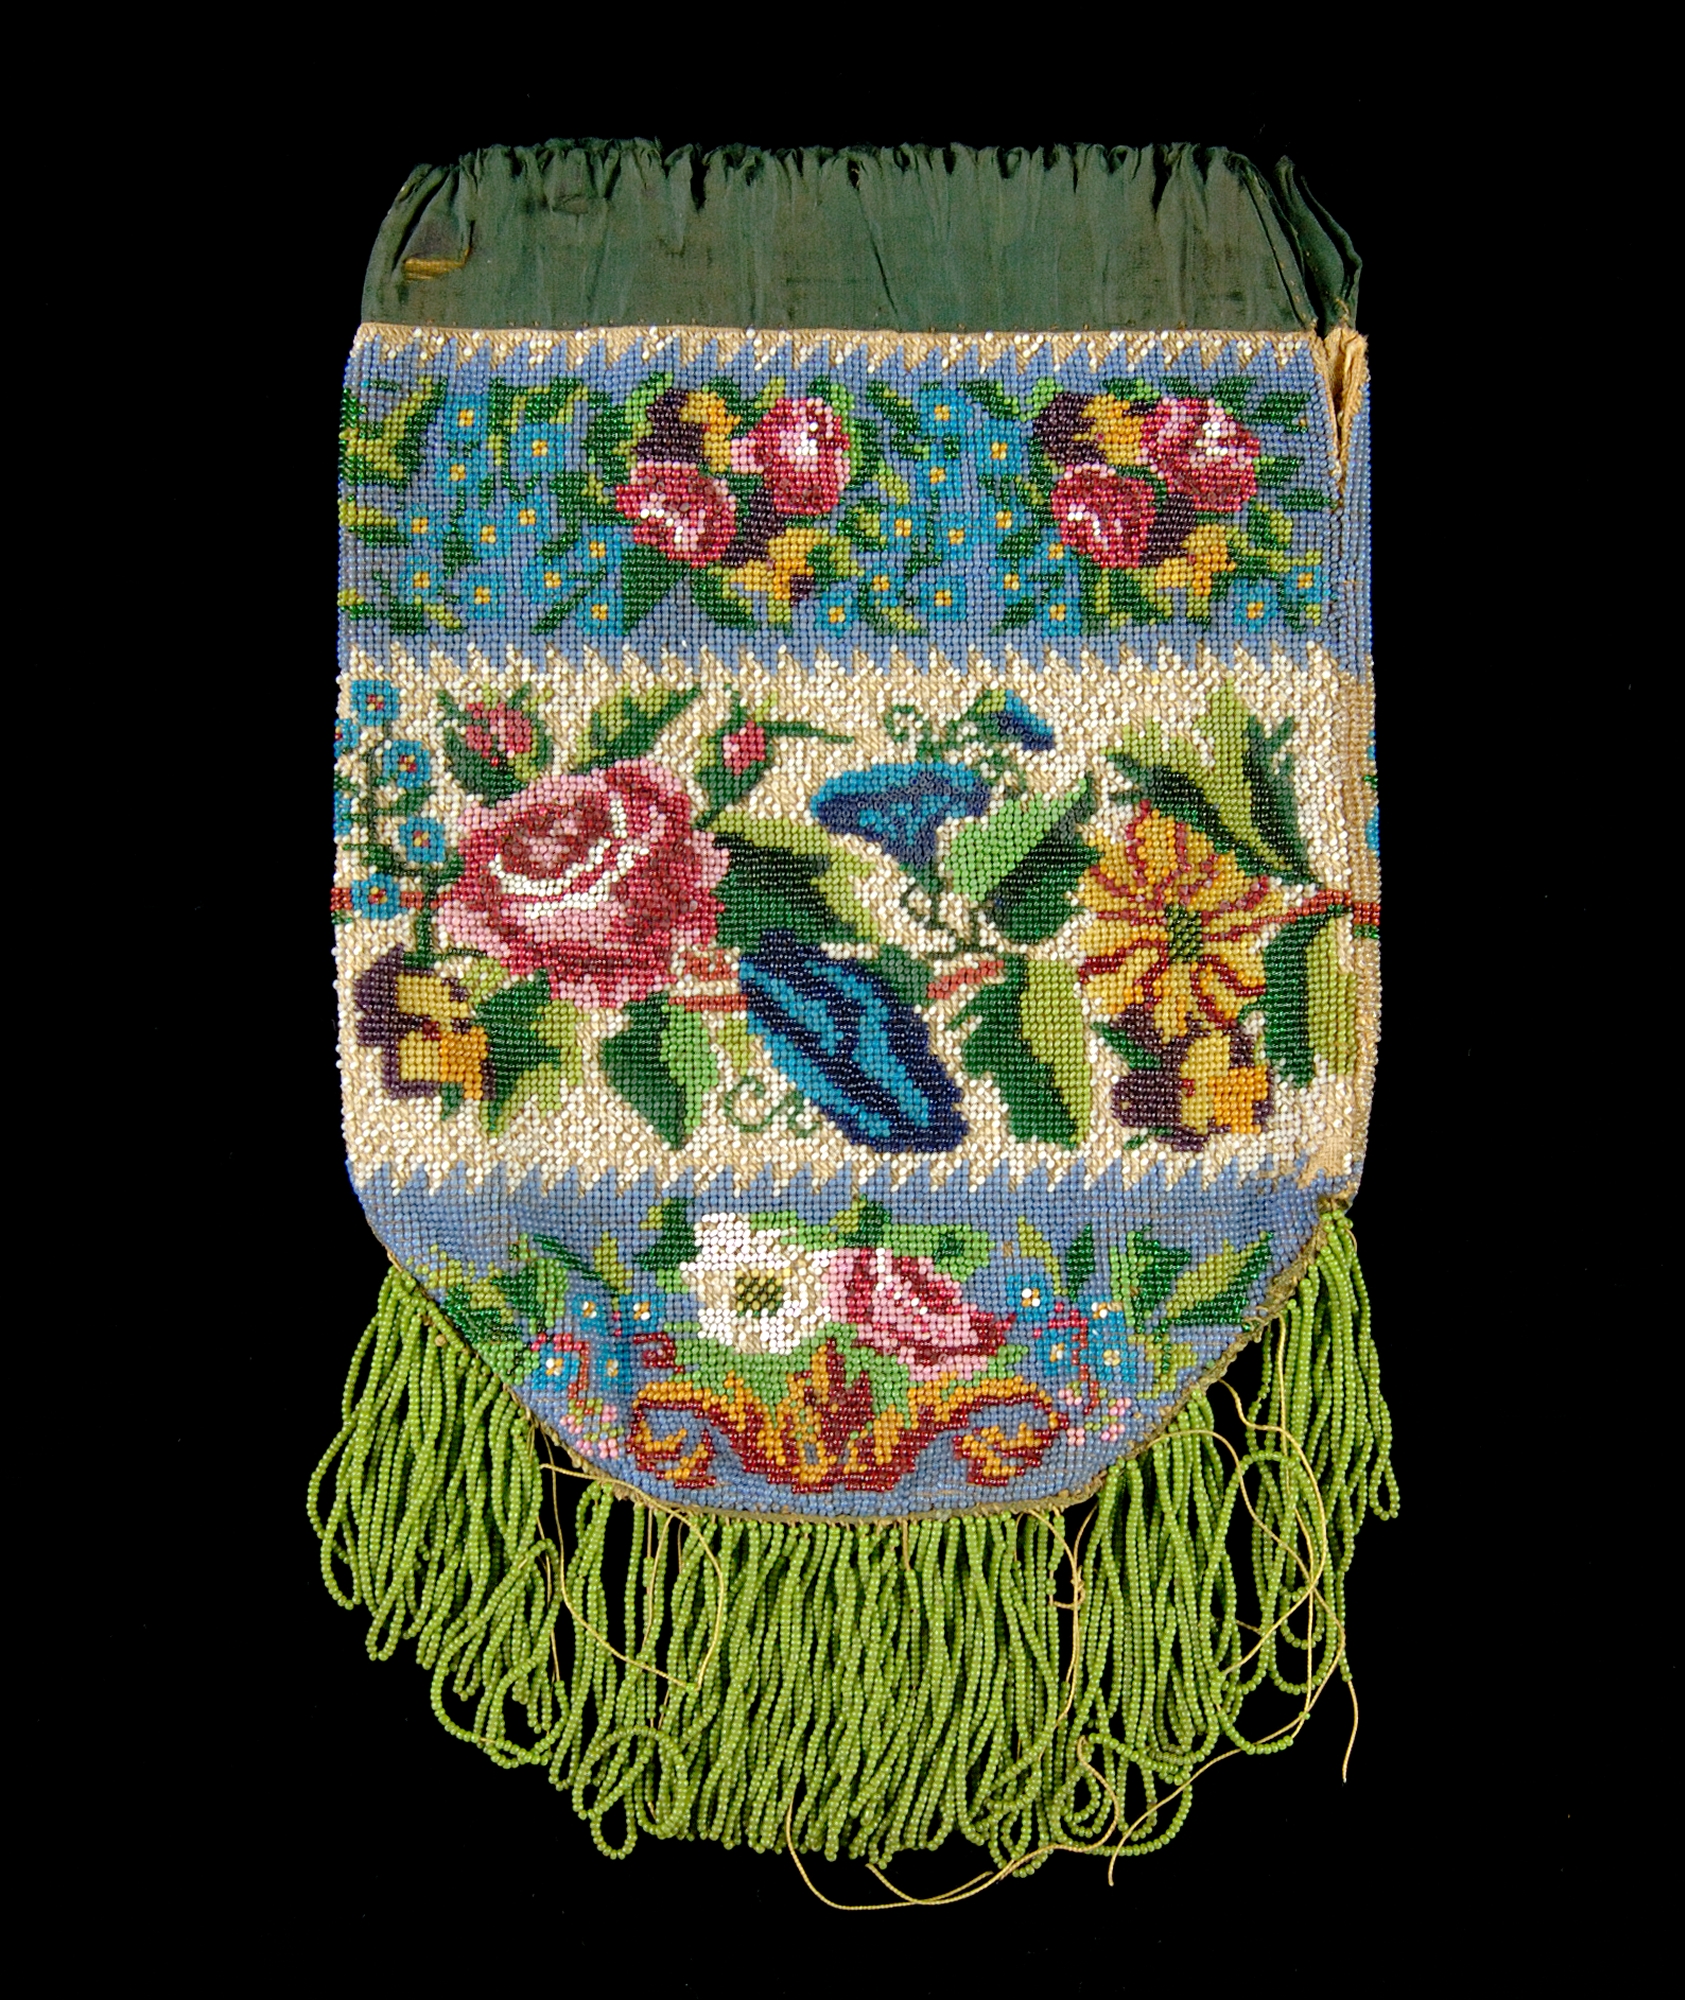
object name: pouch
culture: american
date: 1830-1860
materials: glass, linen, silk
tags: flowers